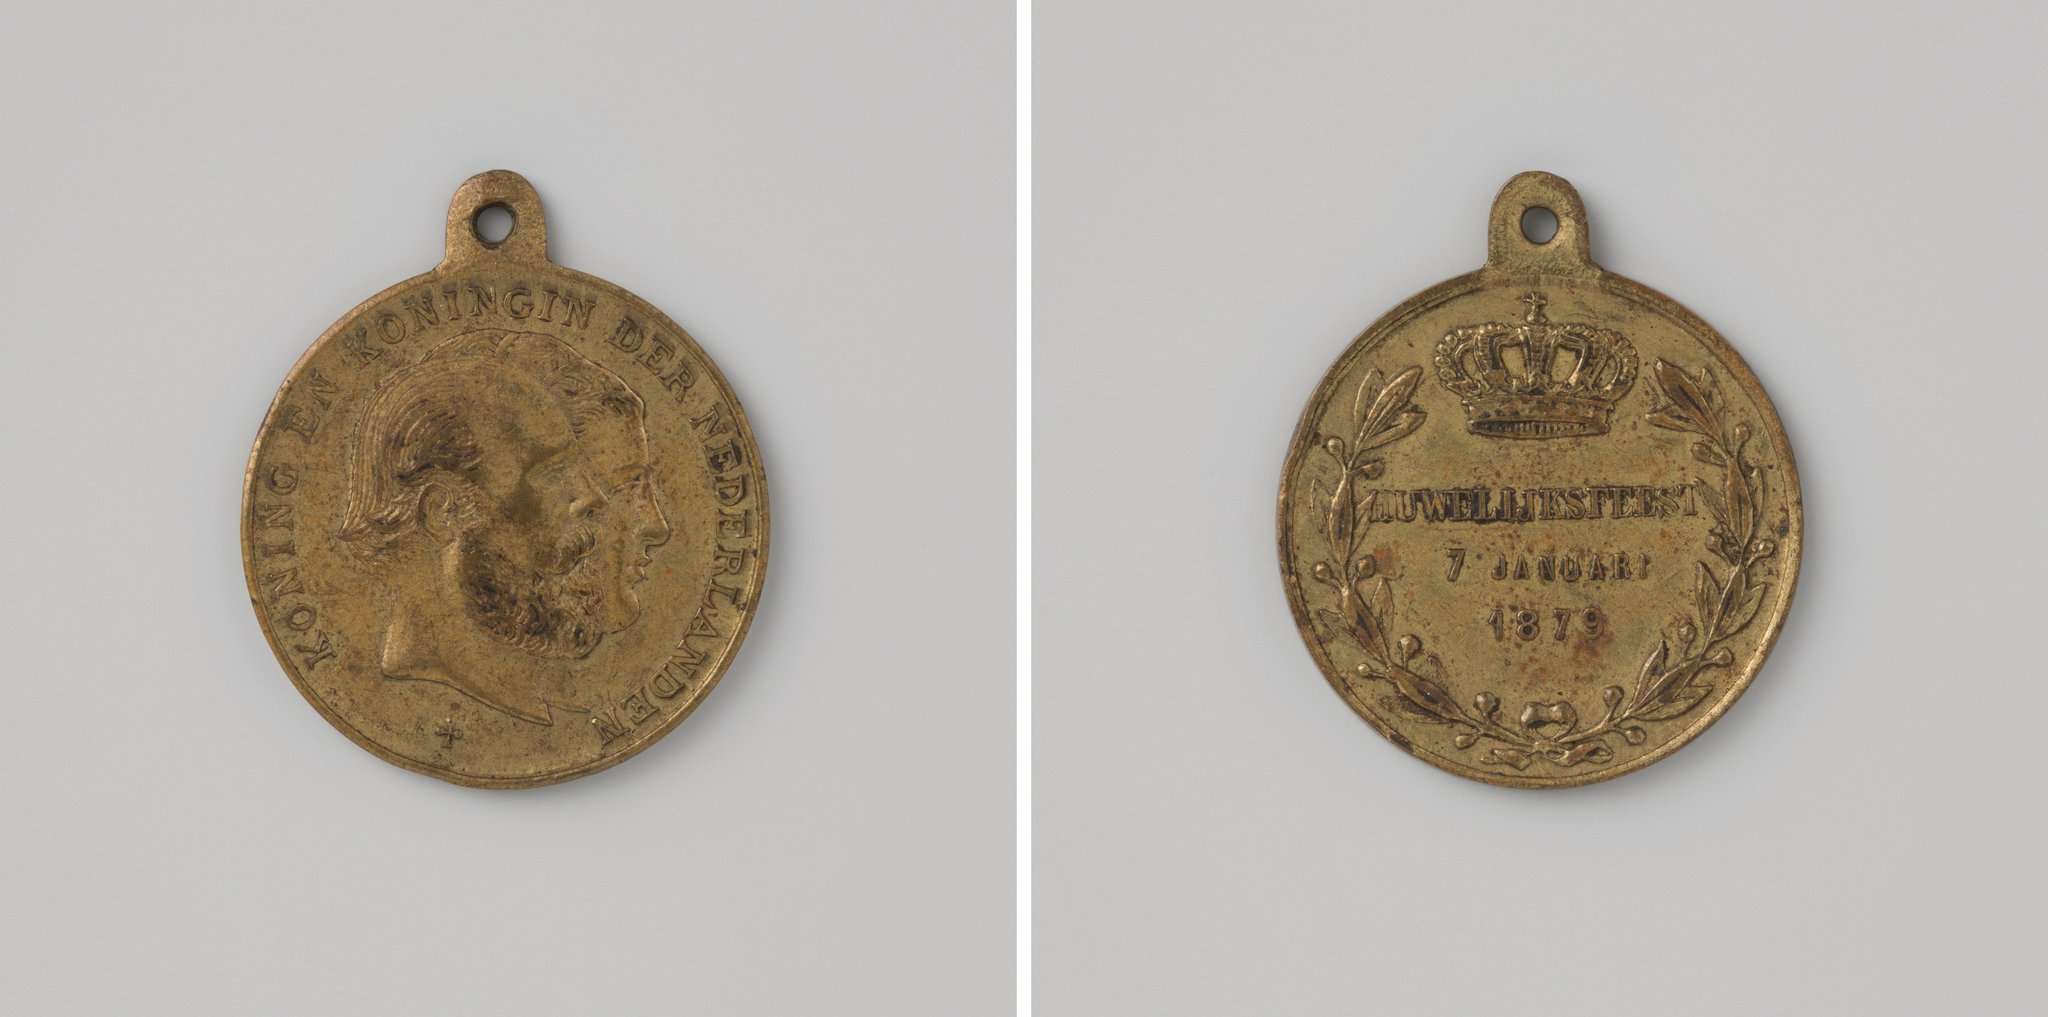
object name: history medal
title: Huwelijk van Koning Willem III en Emma van Waldeck Pyrmont 1879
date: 1879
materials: brass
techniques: striking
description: Messing penning met draagoog, op de voorzijde de geconjugeerde bostbeelden van Willem III en Emma naar rechts met omschrift, op de keerzijde drie regels tekst onder een kroon tussen twee samengestrikte lauwertakken.